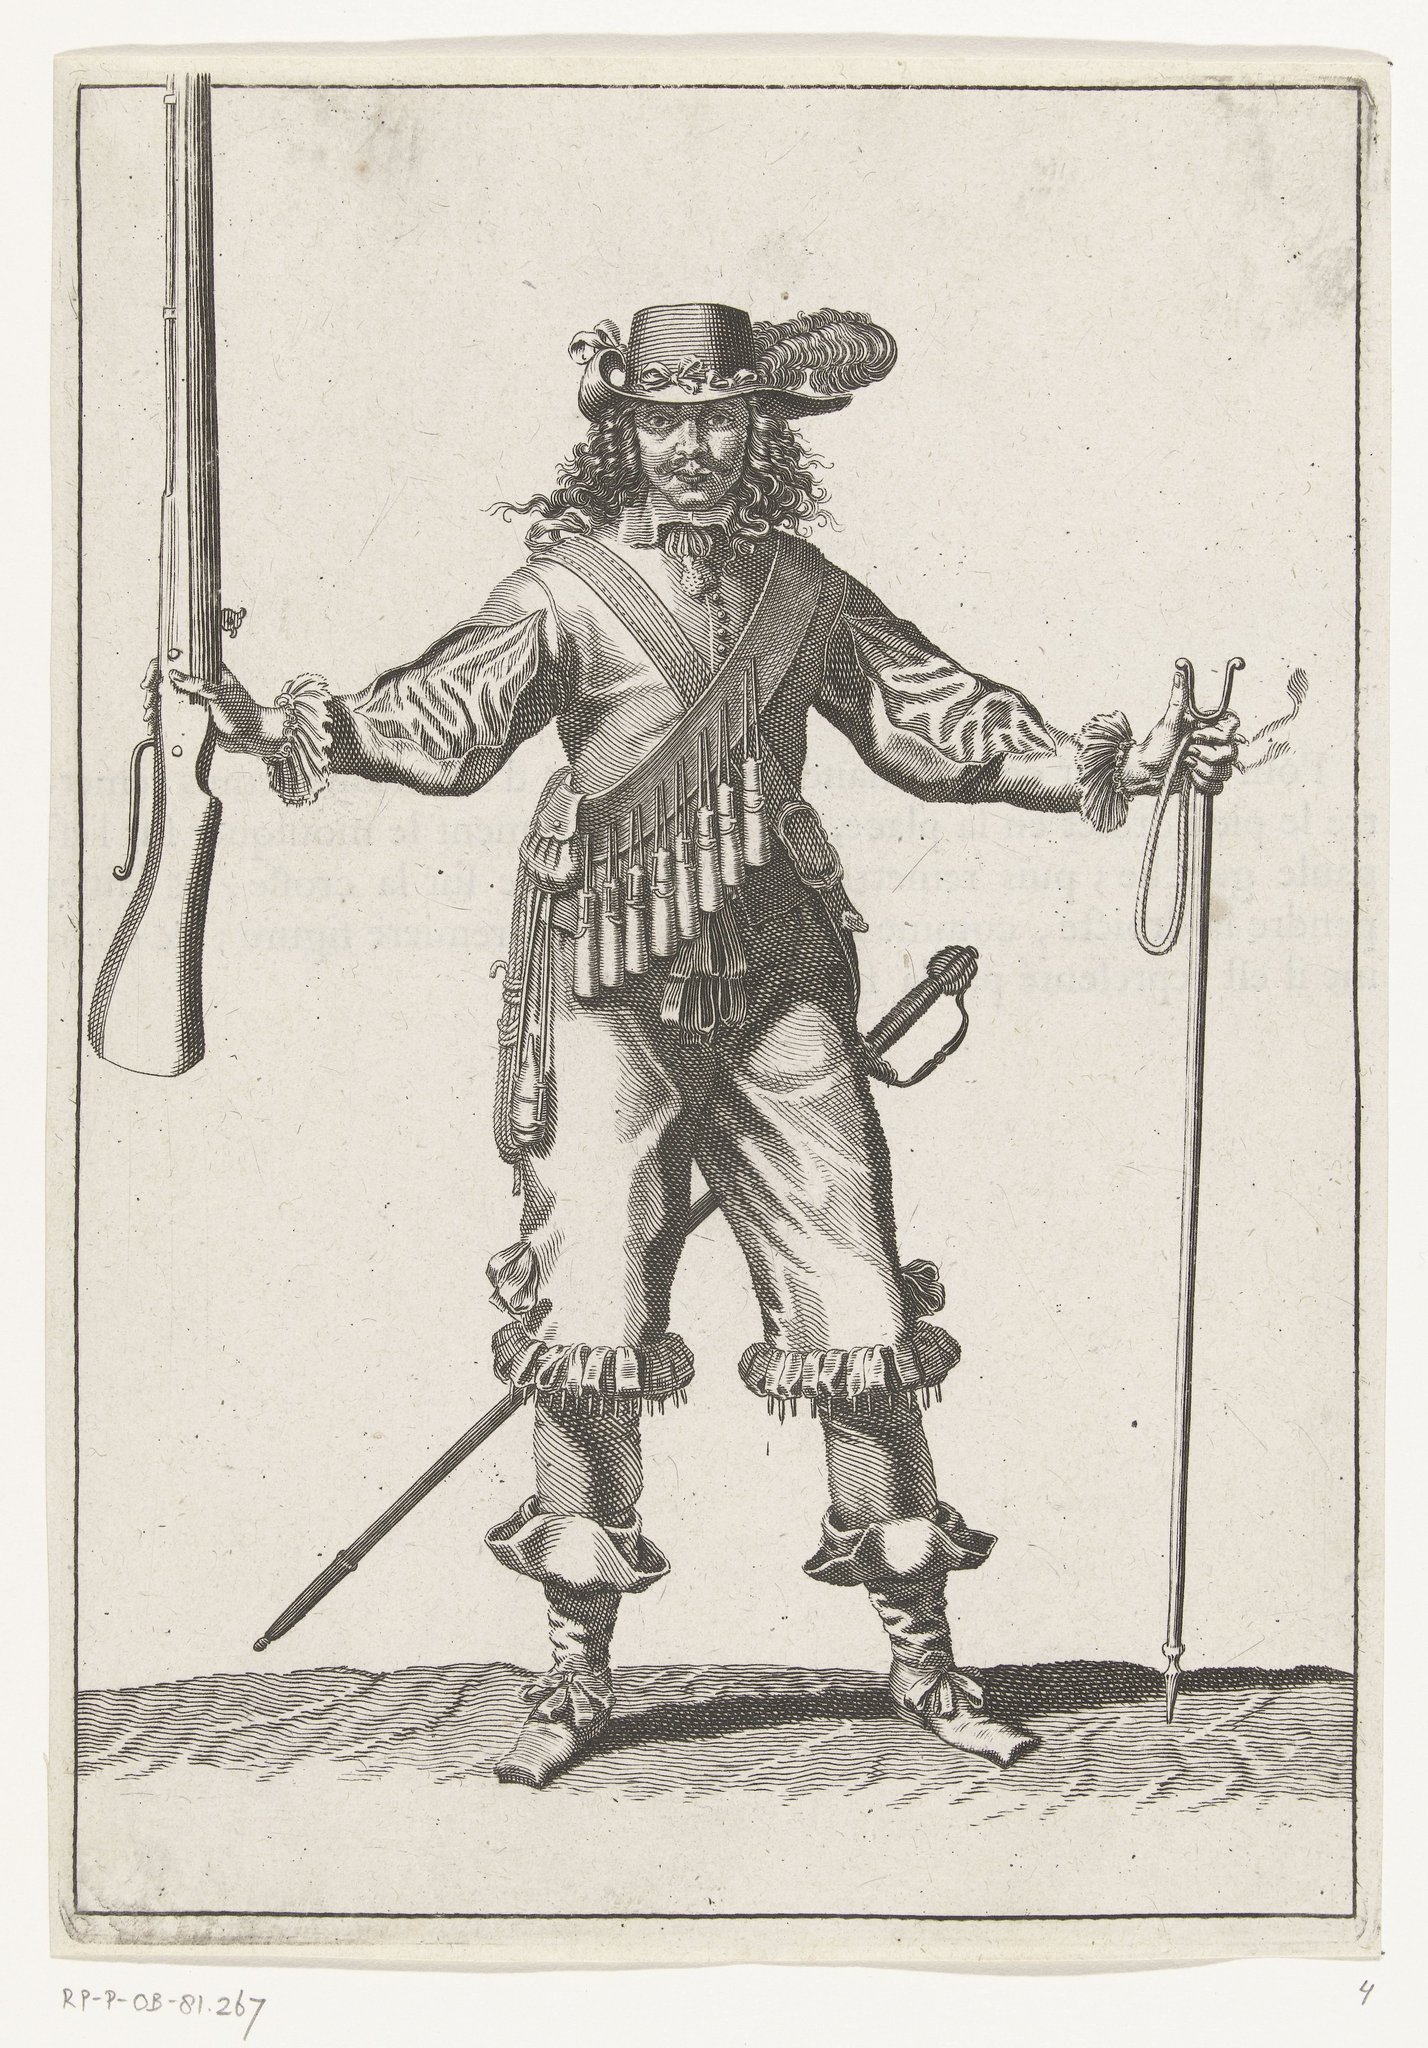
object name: print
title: Soldaat met gestrekte armen houdend zijn musket in zijn rechterhand en zijn furket in zijn linkerhand, ca. 1645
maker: petrus rucholle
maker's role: print maker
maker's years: 1618-1647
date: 1645-1647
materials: paper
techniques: engraving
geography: southern netherlands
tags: handling of weapons ~ military training, weapons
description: Een soldaat, ten voeten uit, gezien van voren, die met gestrekte armen een musket (een bepaald type vuurwapen) in zijn rechterarm houdt en zijn furket (musketvork) met brandende lont in zijn linkerarm, ca. 1645. Bedrukt op achterzijde met tekst in het Frans. Nieuwe voorstelling niet ontleend aan de instructies voor het hanteren van het musket in de Wapenhandelinghe van J. de Gheyn. Krijgswezen rond 1600.